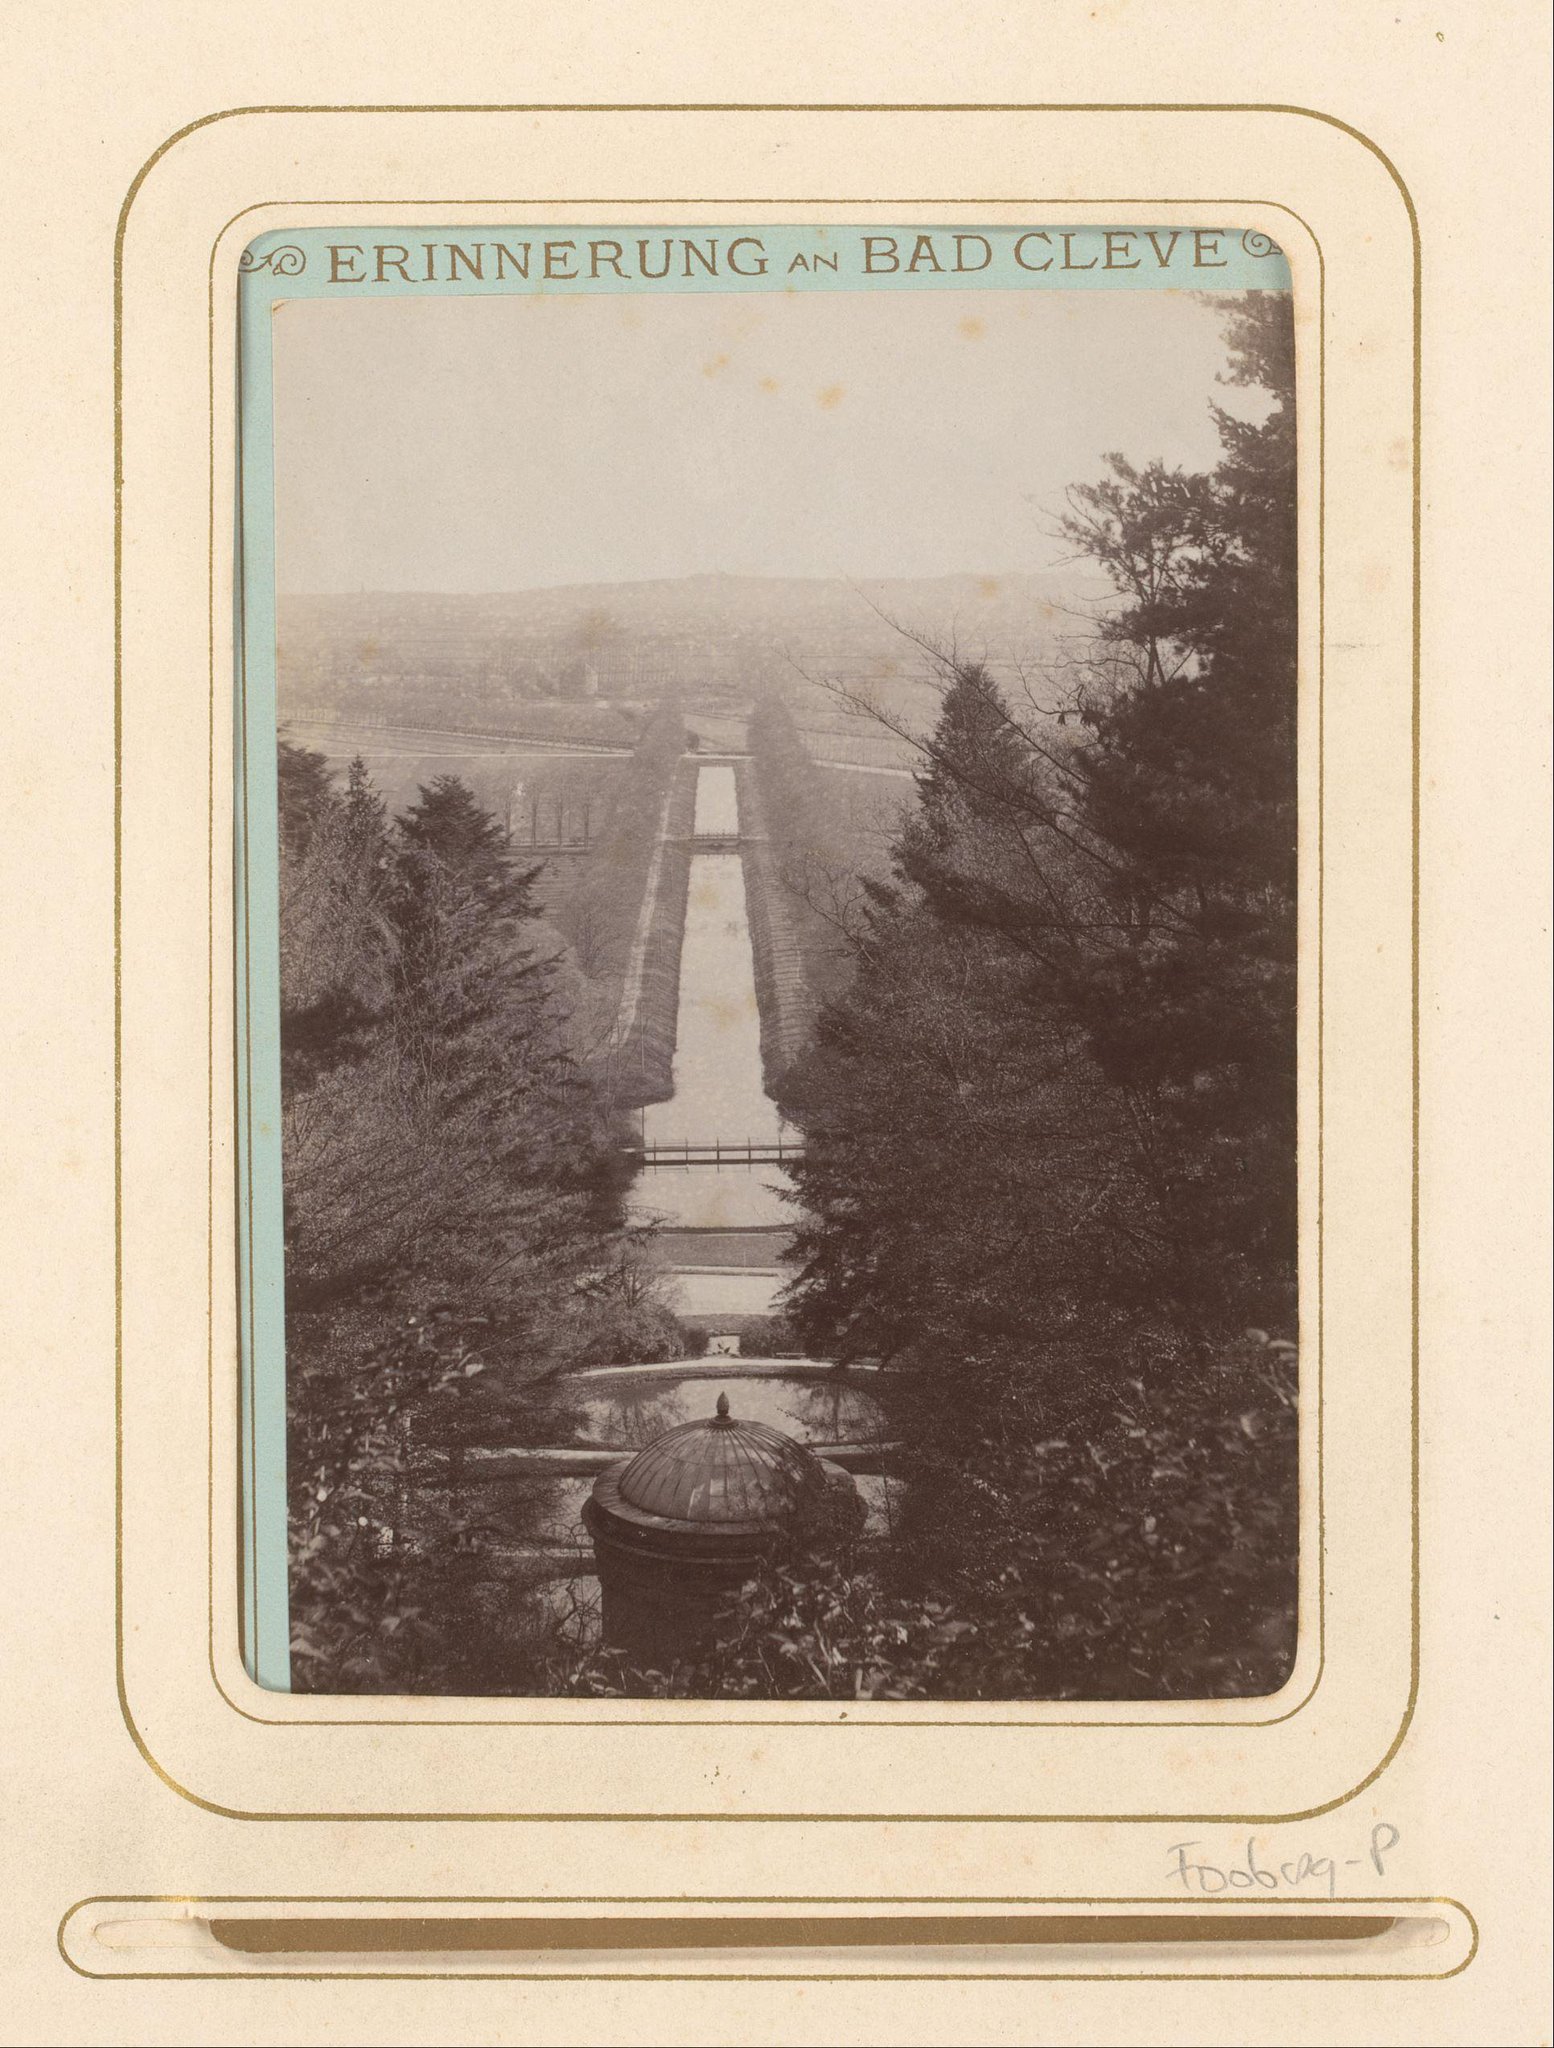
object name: photograph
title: Gezicht op een vijver en koepel te Kleef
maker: max cosman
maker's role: fotograaf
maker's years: 1852-1894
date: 1881-1903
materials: cardboard, photographic support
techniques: albumen print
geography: cleves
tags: landscapes in the temperate zone, public gardens, park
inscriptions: inscription: ‘Erinnerung an Bad Cleve/ M. Cosman/ Hoffotograf/ Amsterdam/ Bad Cleve’